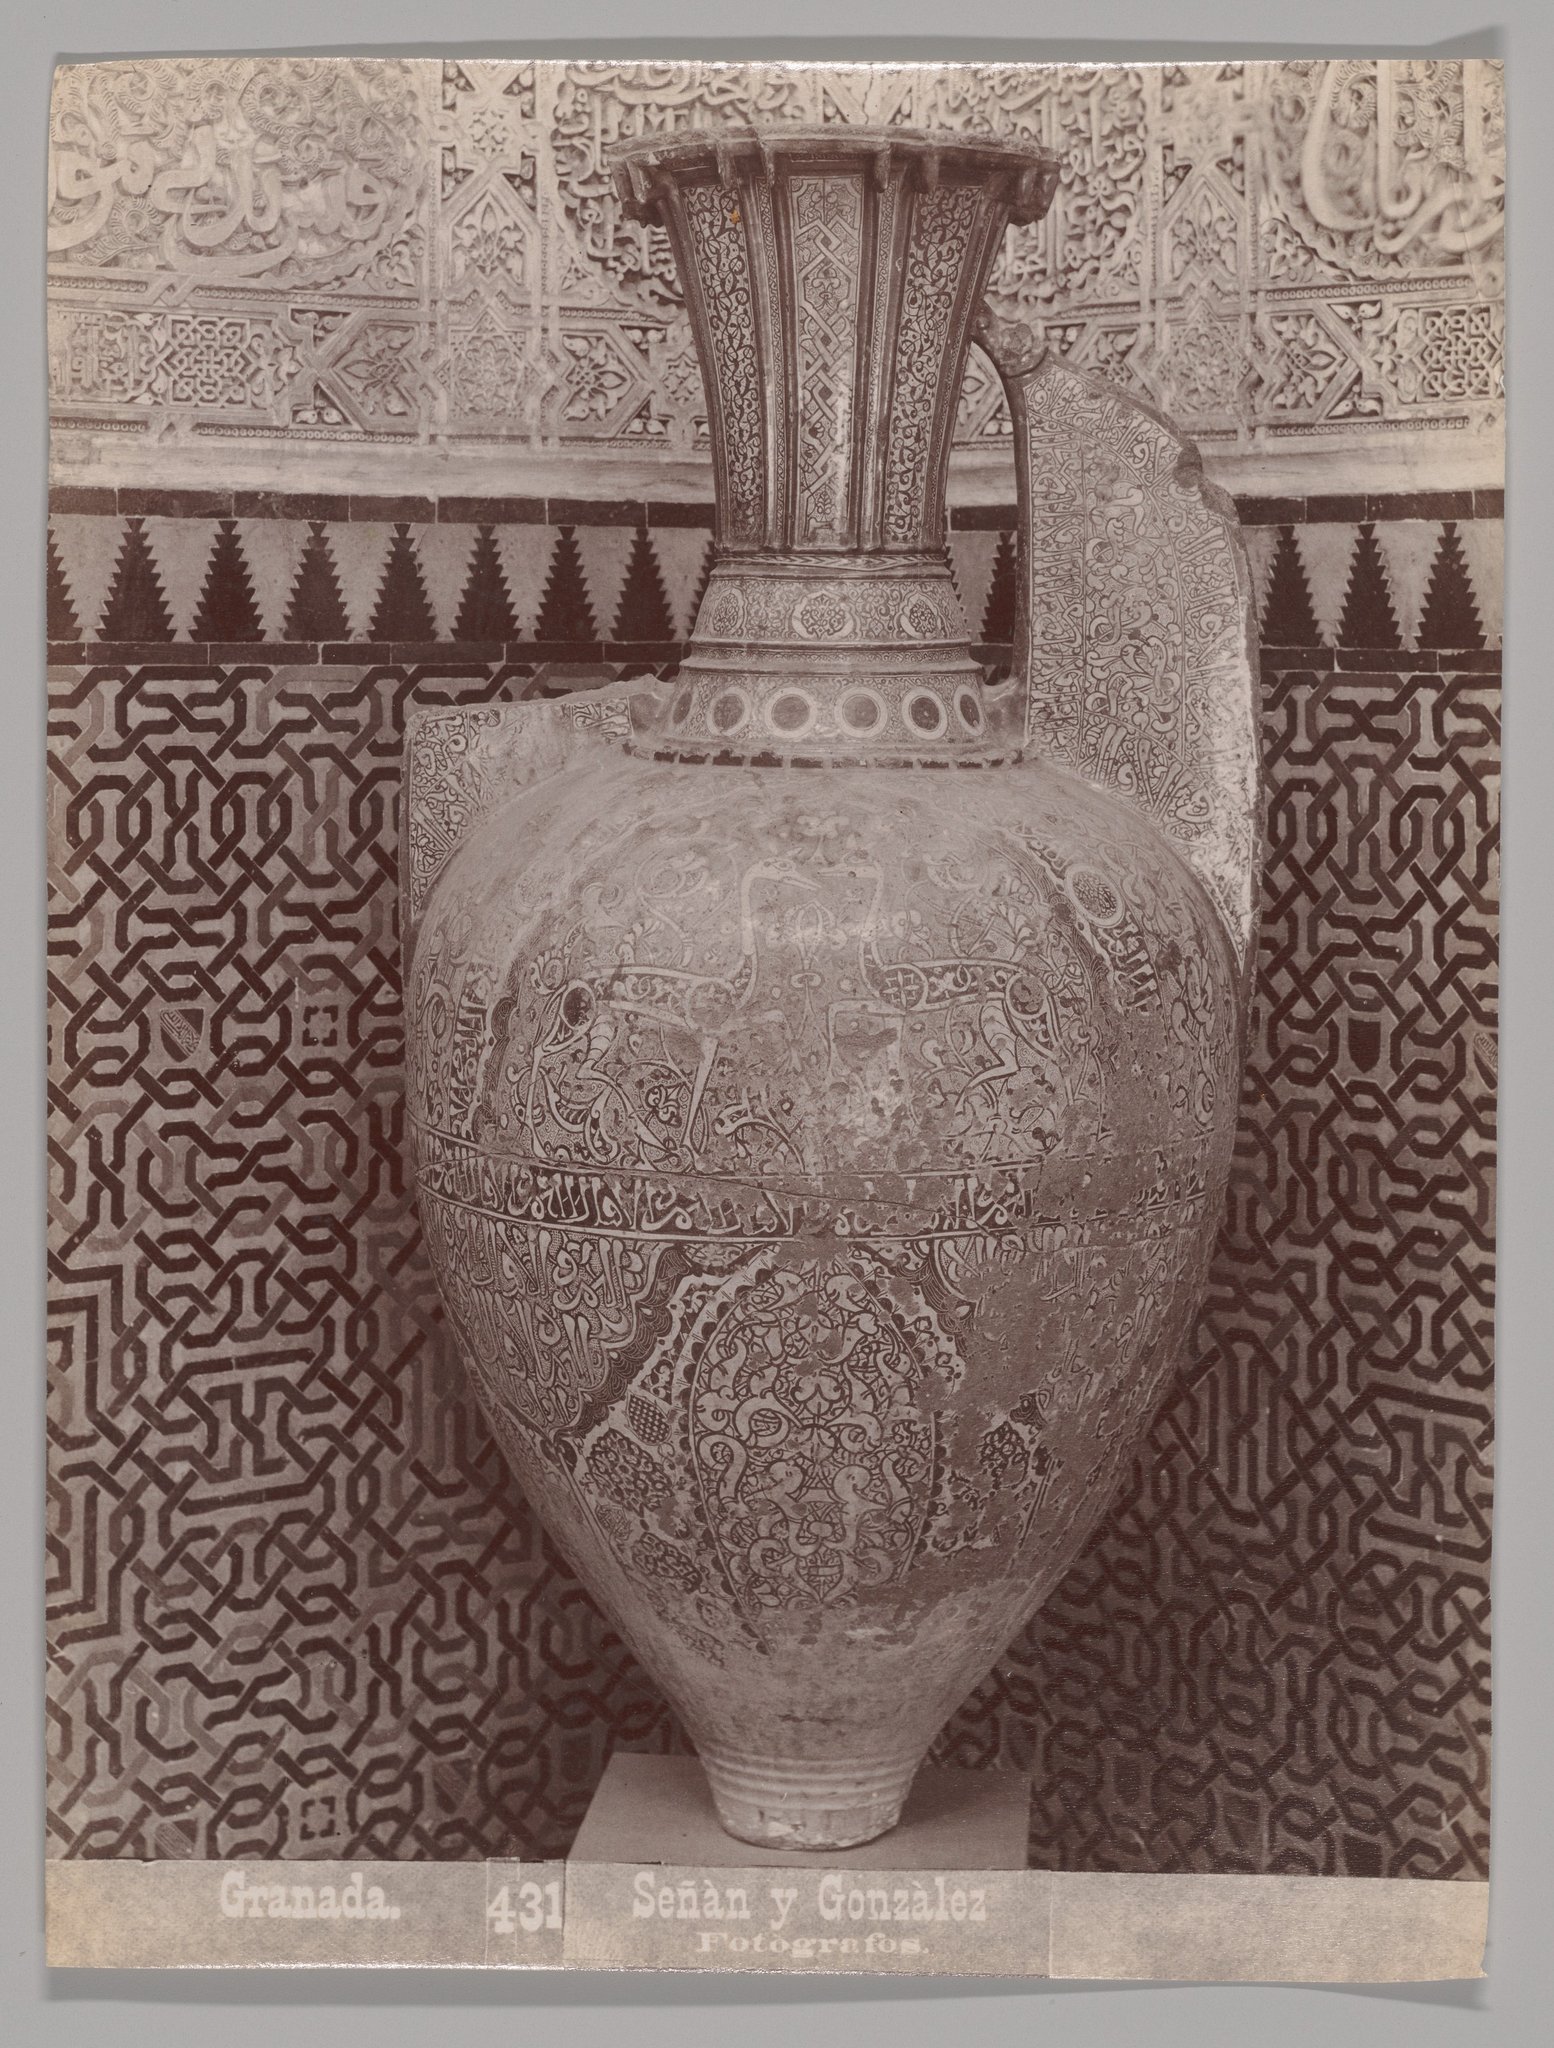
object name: photograph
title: [Moorish Vase, Granada]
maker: señan y gonzalez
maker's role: artist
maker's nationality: spanish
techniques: albumen silver print, glass negative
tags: vases